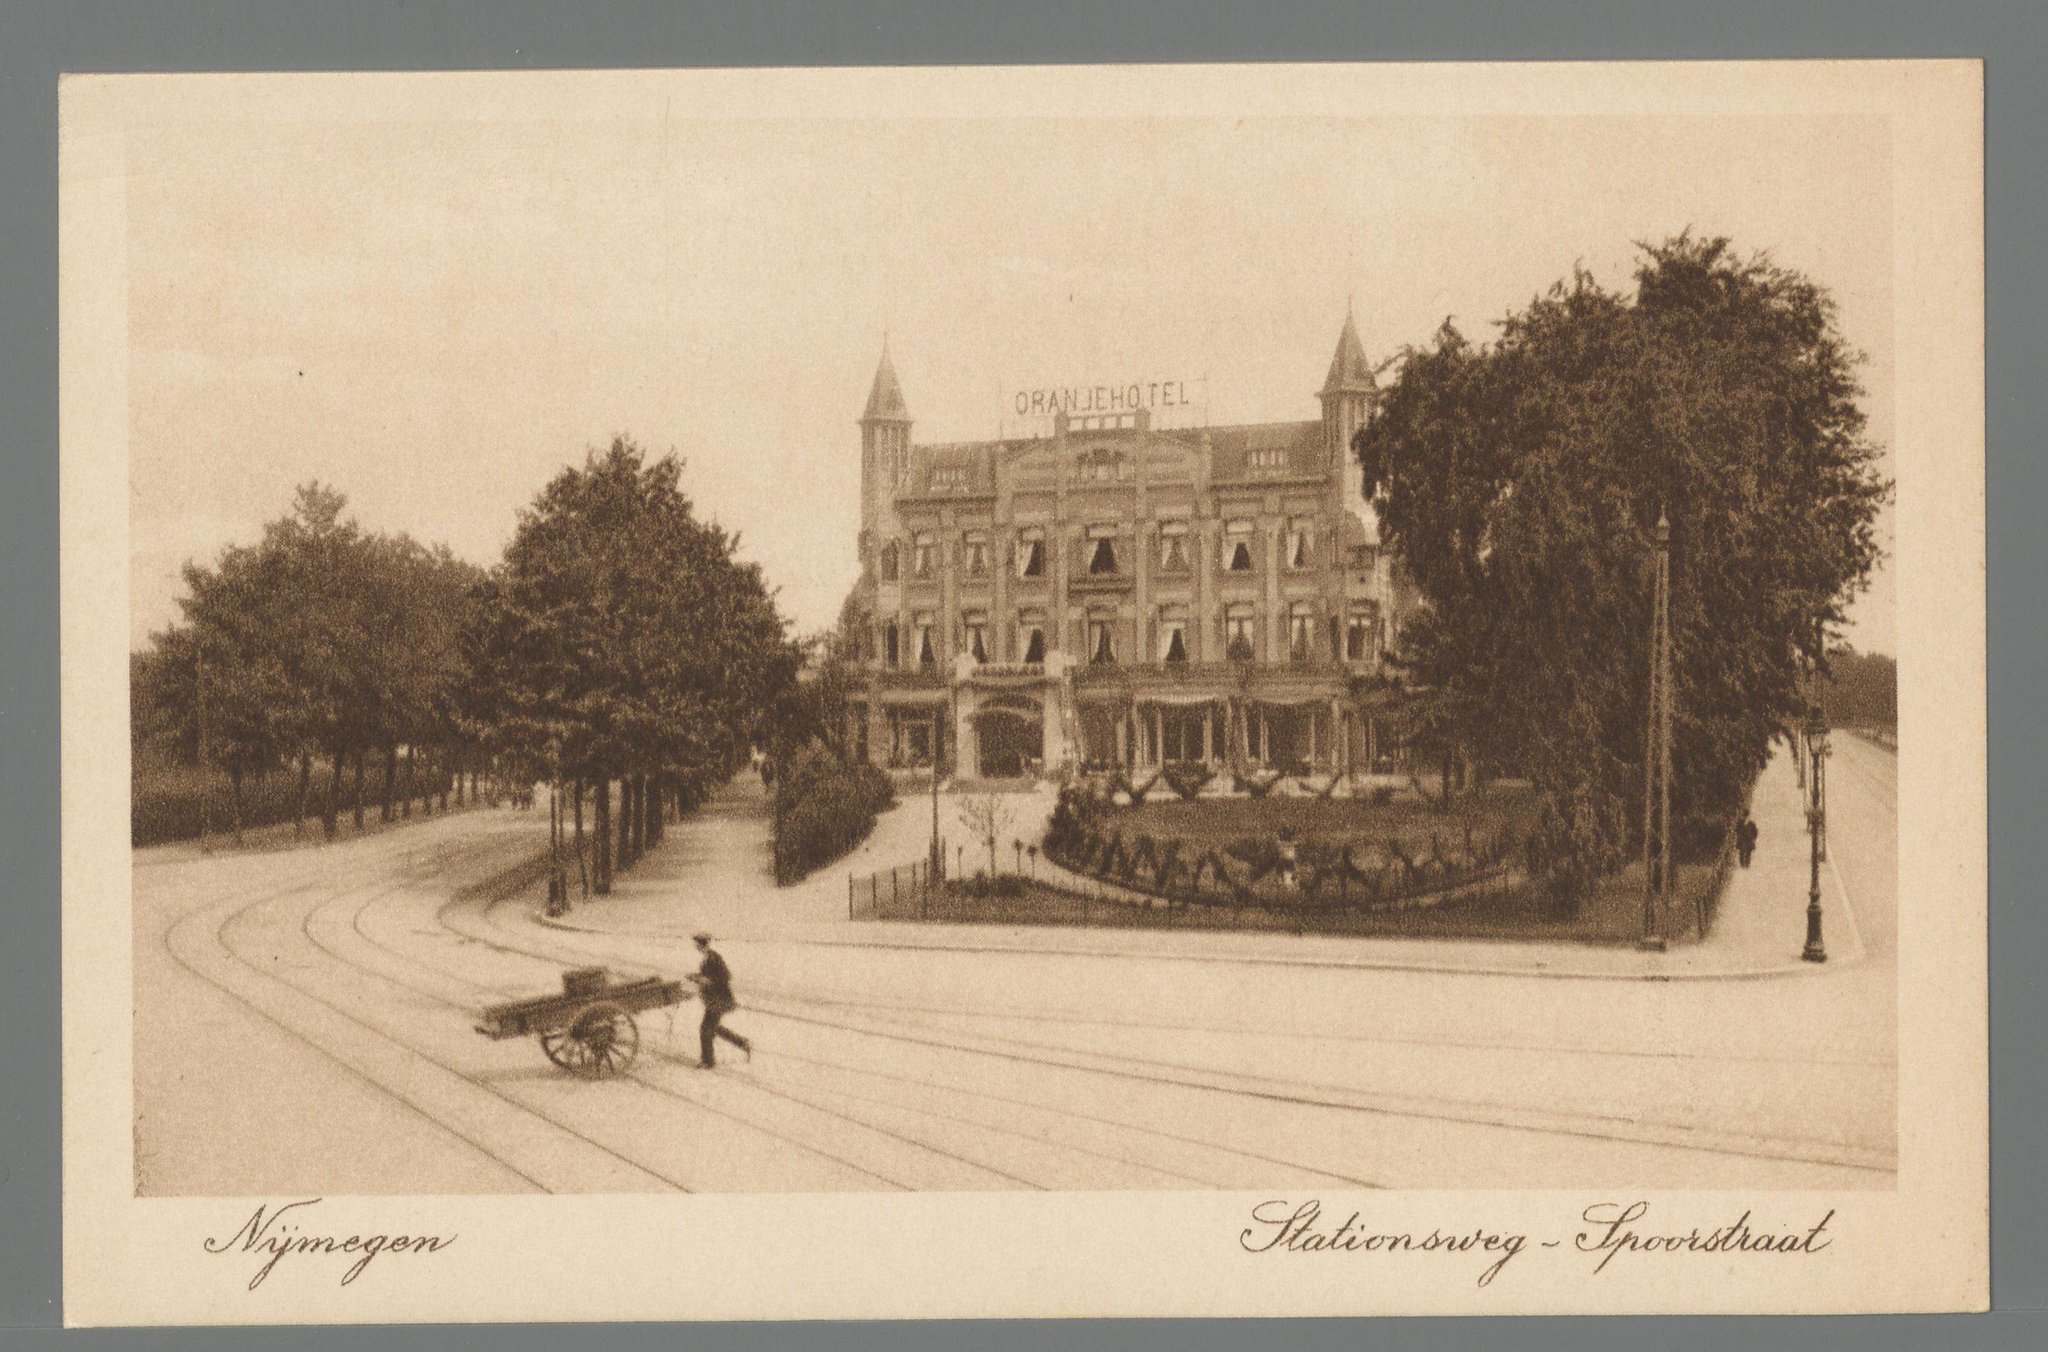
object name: ansichtkaart, prentbriefkaart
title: Nijmegen. Stationsweg - Spoorstraat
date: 1913-1930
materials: cardboard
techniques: rotogravure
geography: nijmegen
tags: railway, train, street, hotel, hostelry, inn, nijmegen